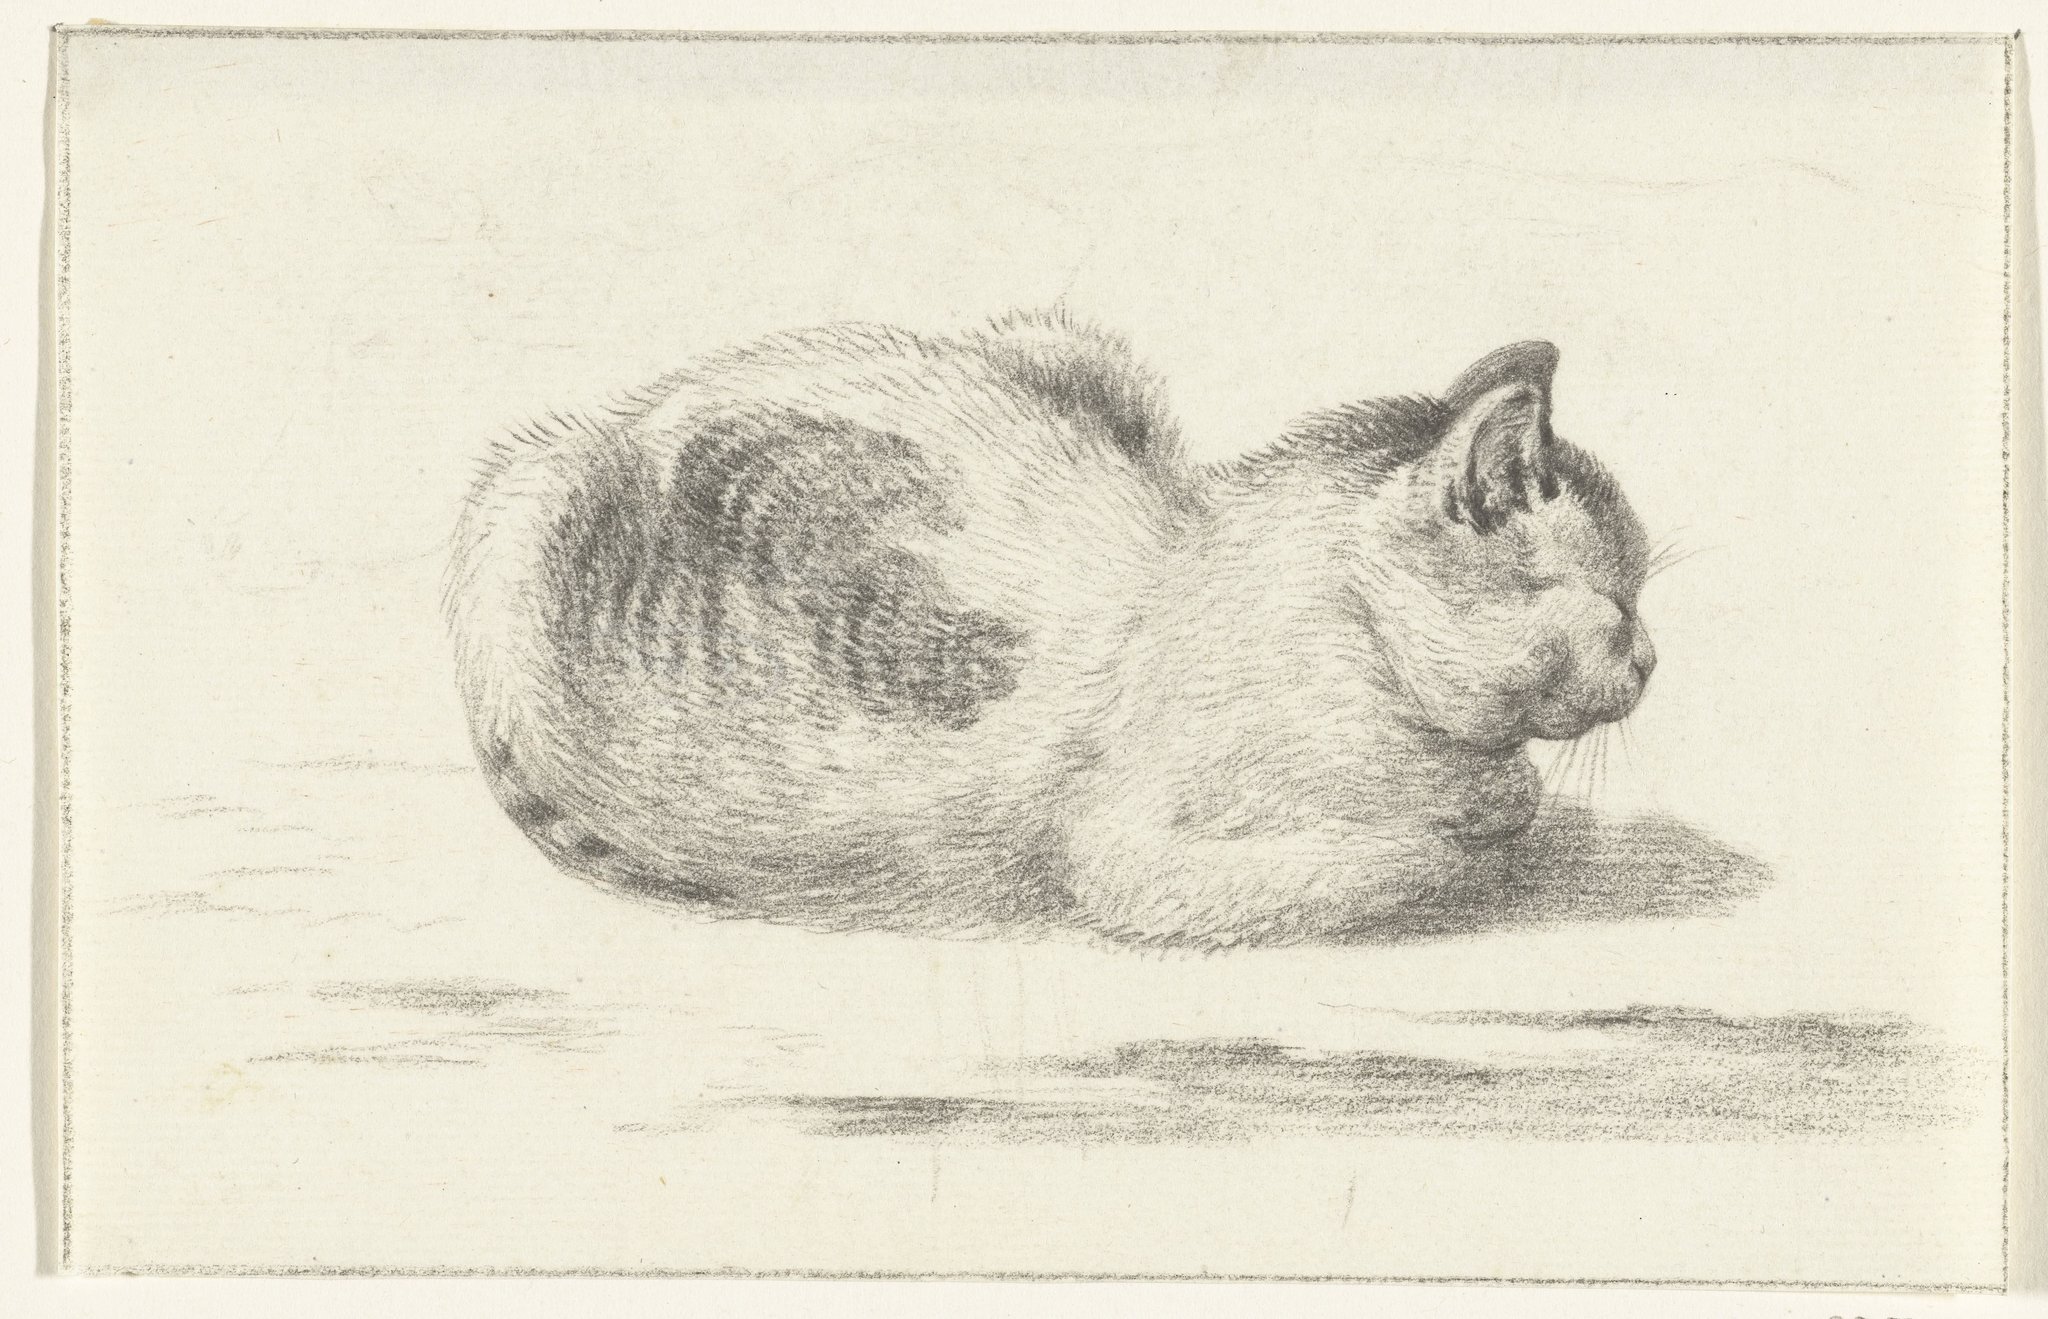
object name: drawing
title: Liggende kat, naar rechts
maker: jean bernard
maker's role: draughtsman, print maker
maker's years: 1765-1833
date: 1775-1833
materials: chalk, paper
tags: cat